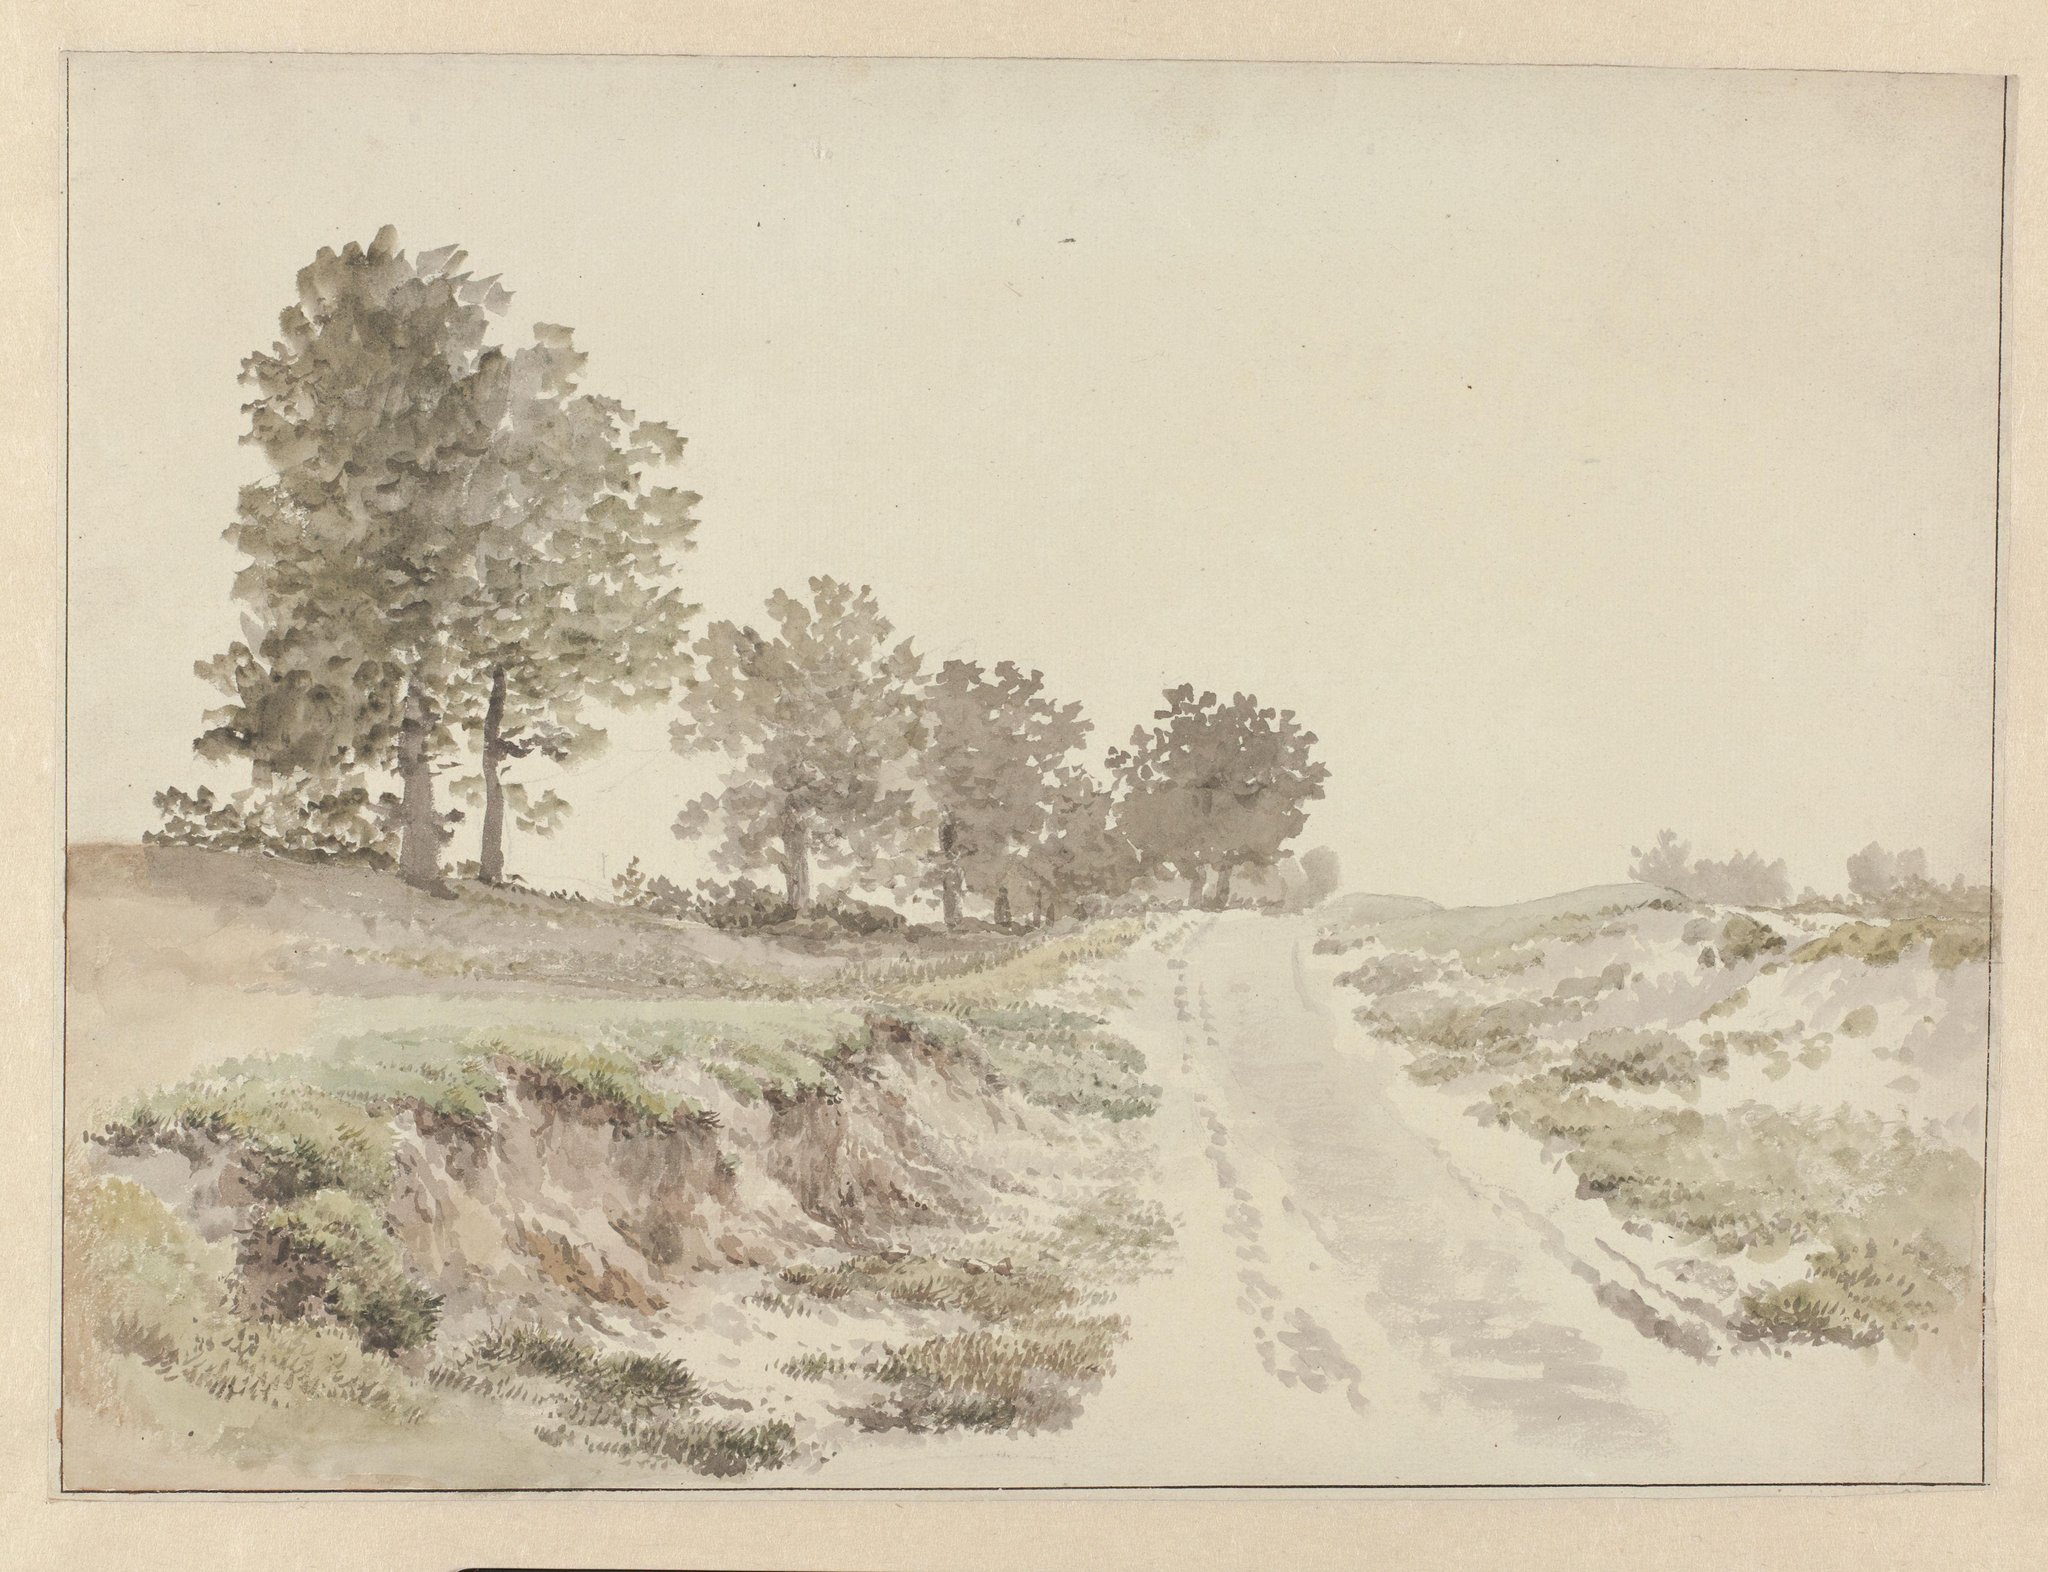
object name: watercolor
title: Landschap (in Drente?)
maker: Anonymous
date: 1800-1900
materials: chalk, paper, watercolor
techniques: brush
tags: drenthe